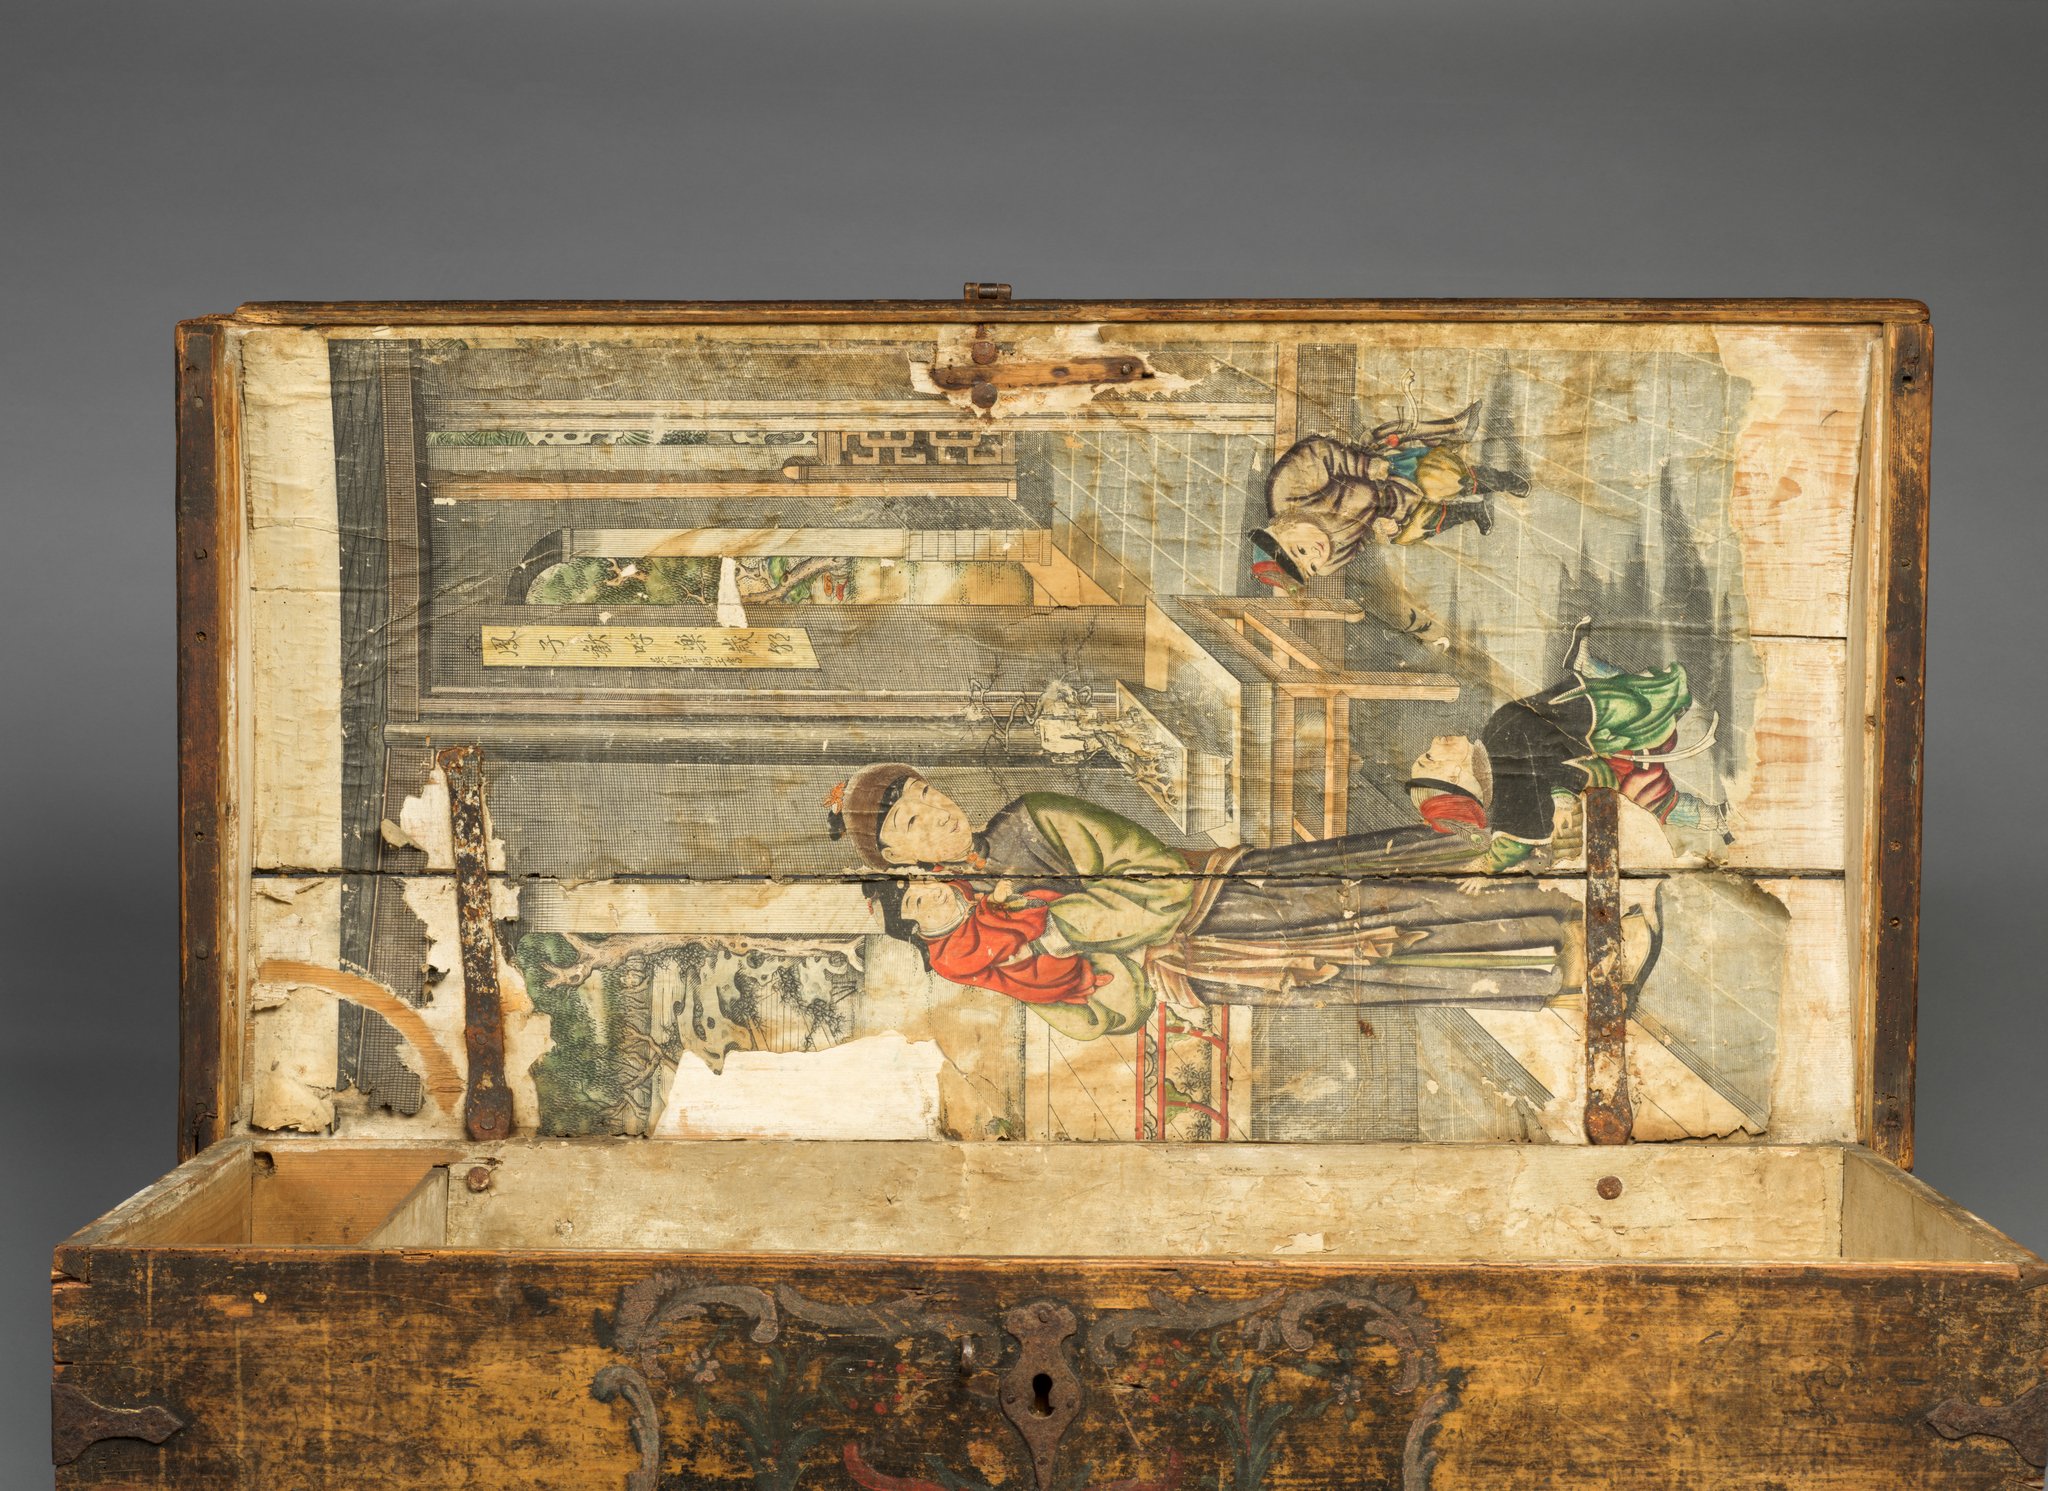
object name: chest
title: Wooden chest with print "Gusu Beauty in Winter" pasted inside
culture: chinese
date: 1767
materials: ink, paper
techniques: polychrome, woodblock print